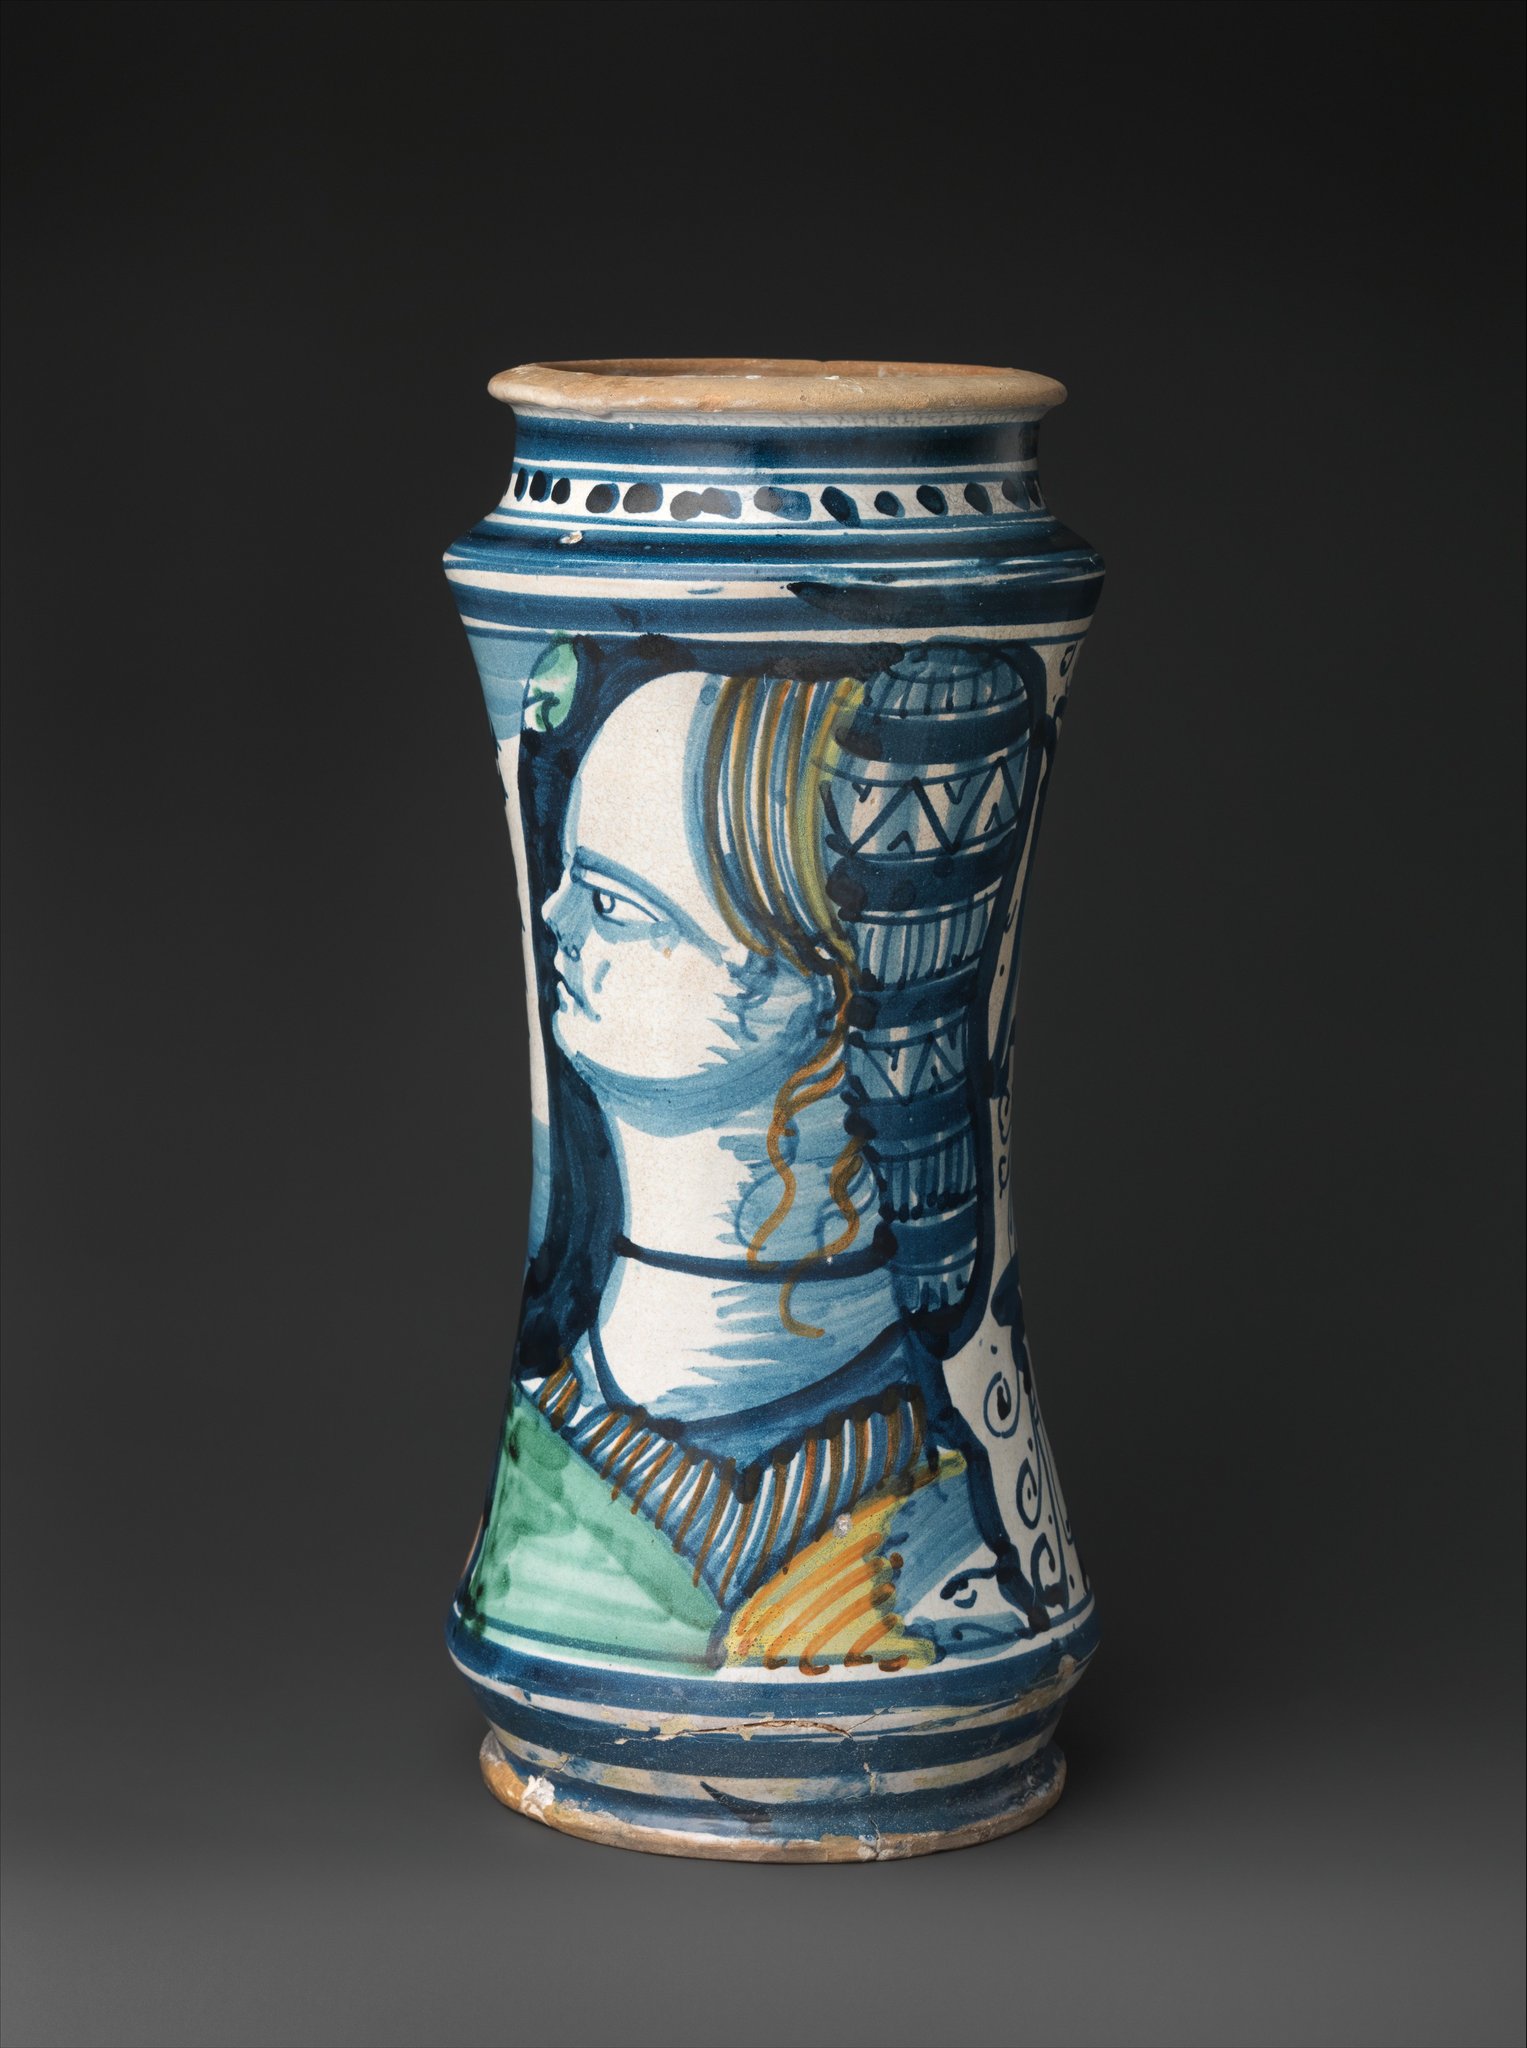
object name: pharmacy jar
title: Pharmacy jar (albarello)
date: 1530-1560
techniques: maiolica, glazing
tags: profiles,women